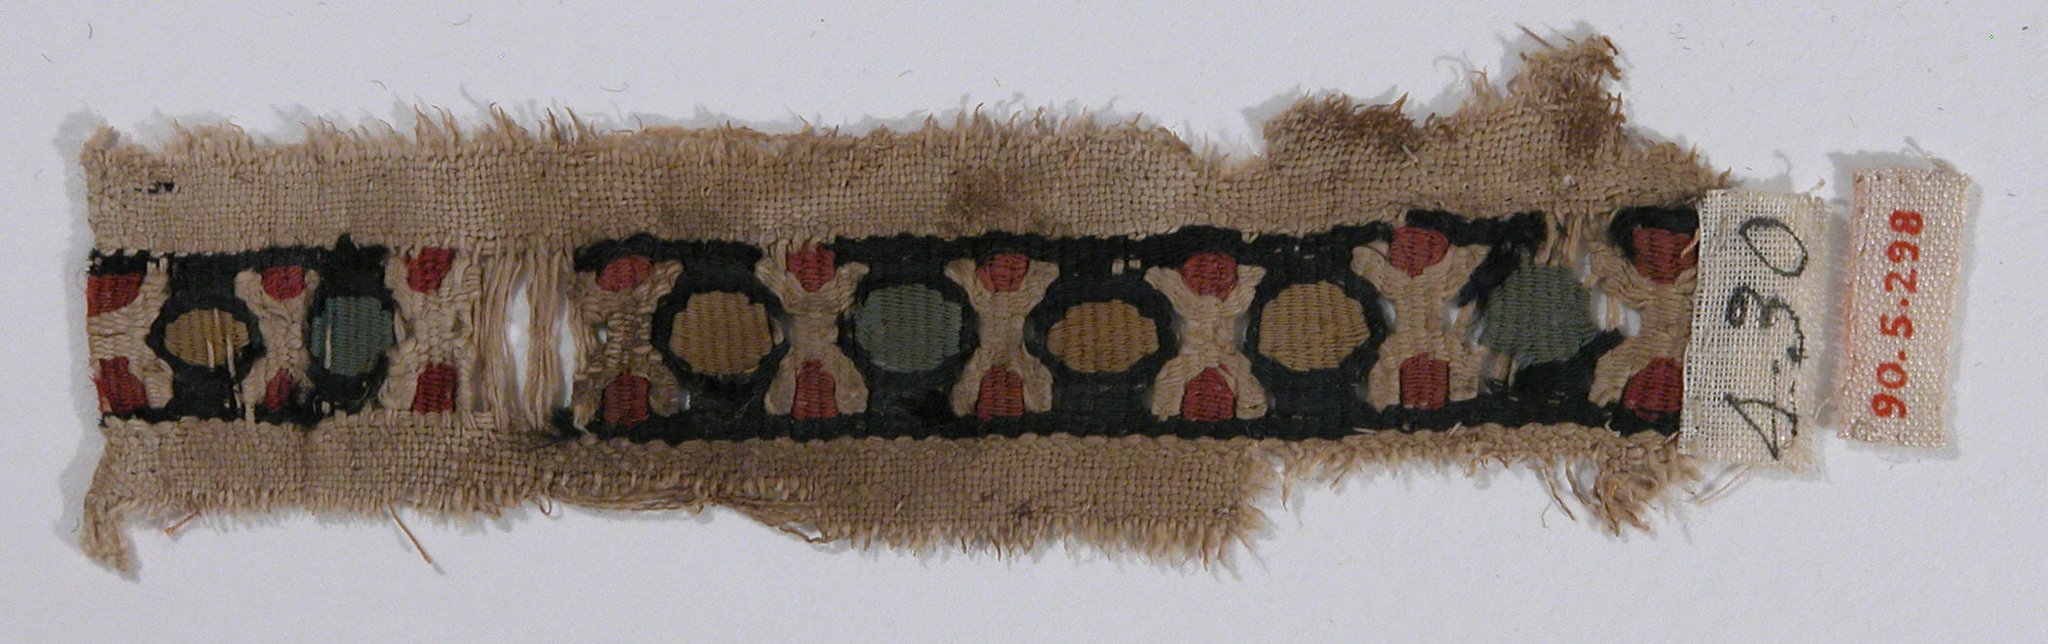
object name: textile fragment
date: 401-600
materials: linen, wool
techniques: weave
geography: egypt